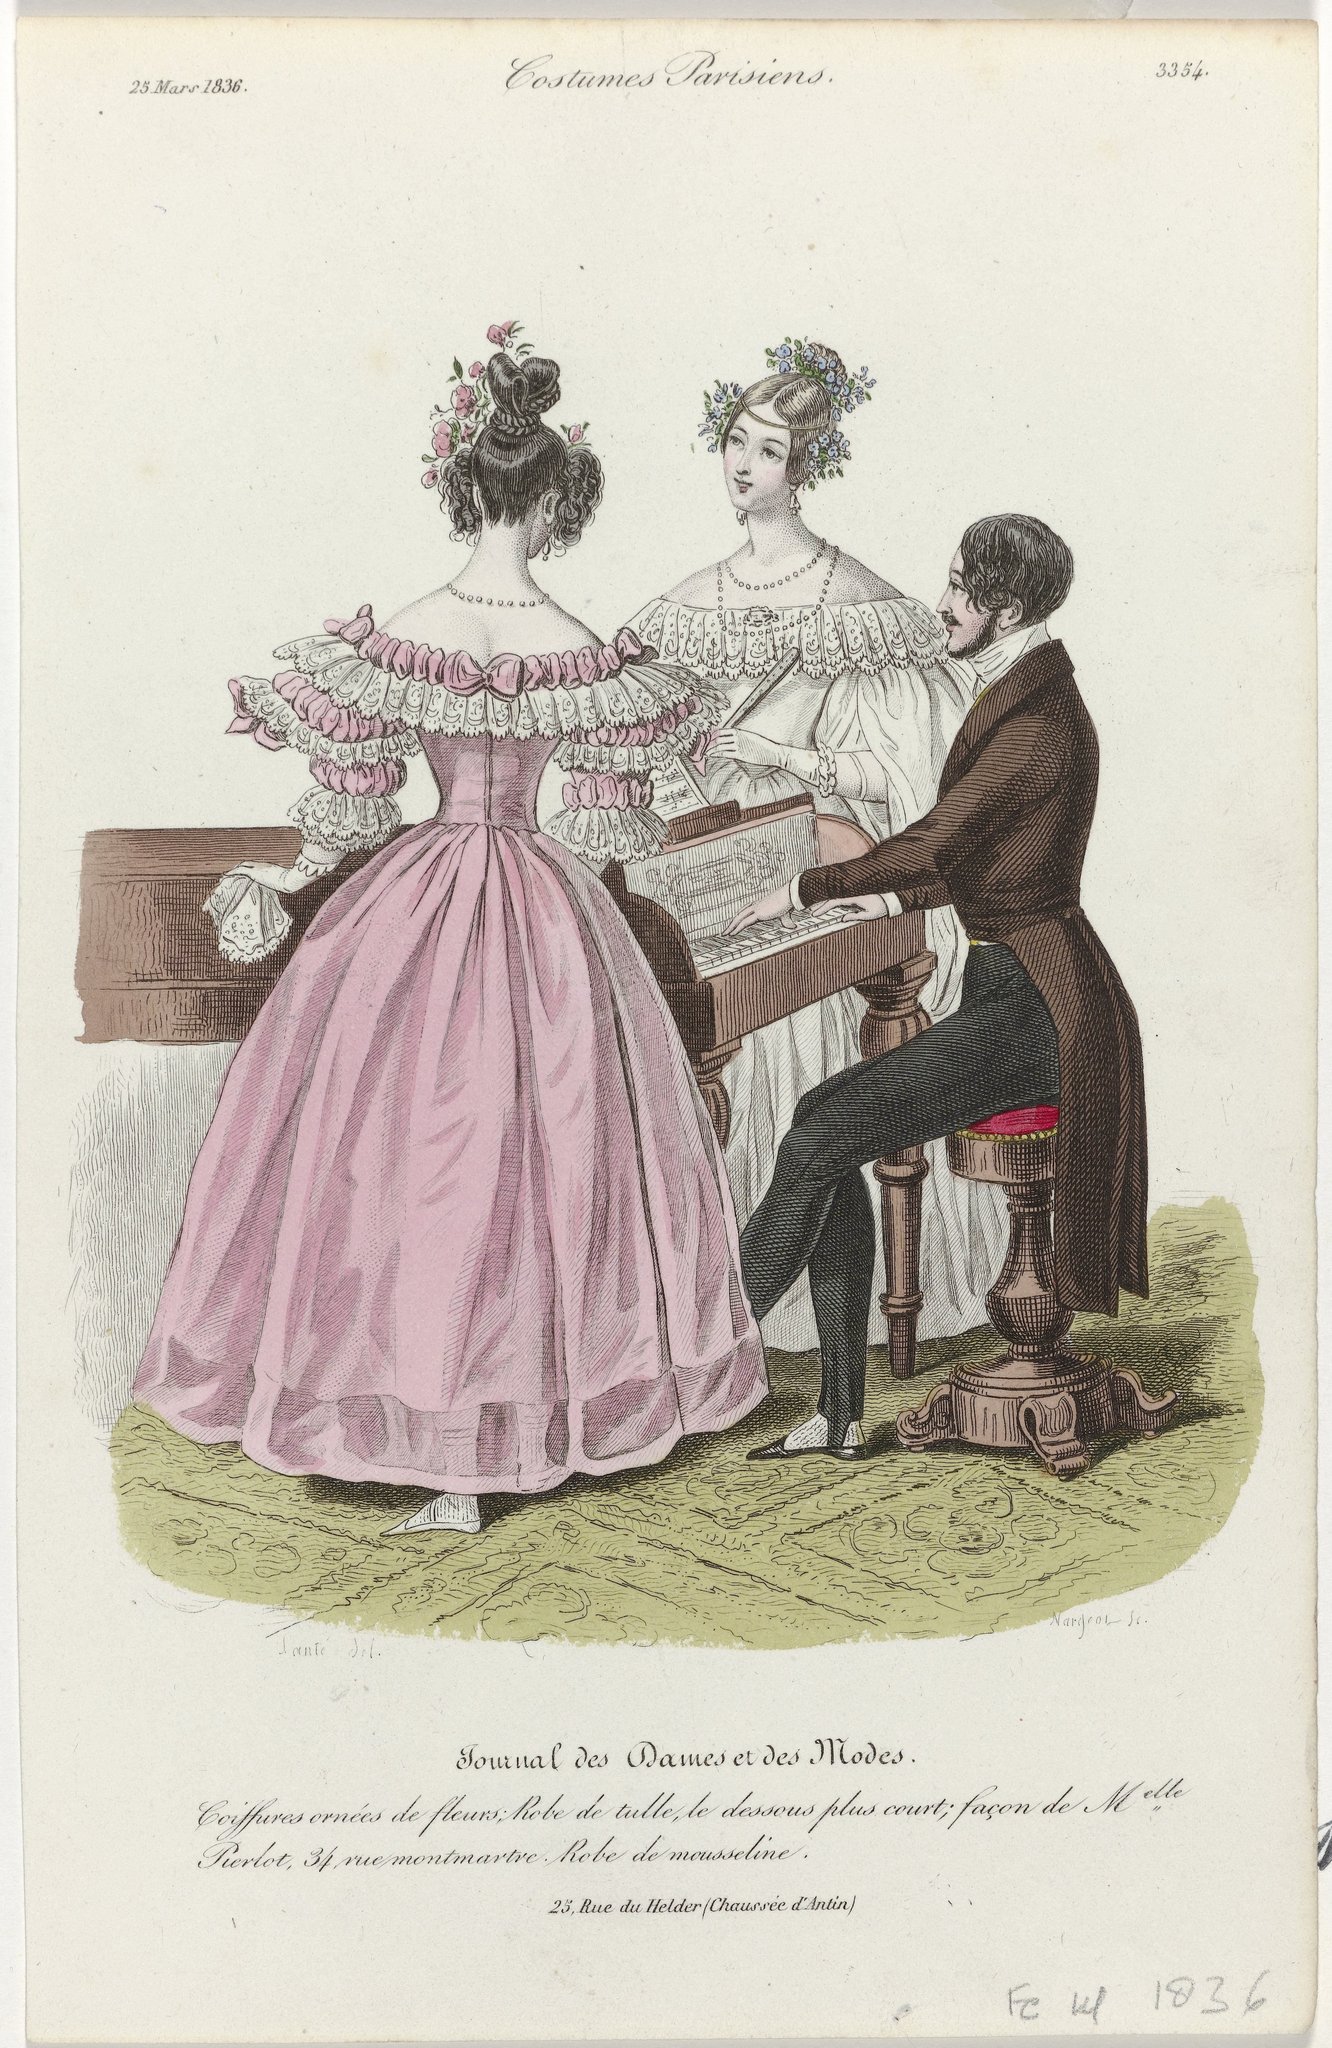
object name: fashion print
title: Journal des Dames et des Modes, Costumes Parisiens, 25 mars 1836, (3354): Coeffures ornées de fleurs (...)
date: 1836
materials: paper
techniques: engraving, hand coloring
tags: flowers, ear-rings (+ women's clothes), handkerchief (+ women's clothes), dress, gown: evening dress (+ women's clothes), grand piano, neck-gear ~ clothing (shawl collar) (+ men's clothes), trousers, breeches, etc. (pantalon) (+ men's clothes), coat (+ men's clothes), styles of hairdress - aa - ~ women, fashion plates, shoes, sandals (+ women's clothes), gloves, mittens, etc. (+ women's clothes), fan (+ women's clothes), necklace (+ women's clothes)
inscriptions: caption: ‘Coiffures ornées de fleurs; Robe de tulle, le dessous plus court; façon de M"elle Pierlot, 34, rue montmartre. Robe de mousseline.’, title: ‘Journal des Dames et des Modes.’, address: ‘25, Rue du Helder (Chaussée d'Antin)’, title: ‘Costumes Parisiens.’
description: Twee vrouwen bij een piano, van wie één op de rug gezien, terwijl een man piano speelt. Hij draagt een bruine jas met slippen op een zwarte spanbroek. Volgens het onderschrift: 'Coiffures' versierd met bloemen. Avondjapon van tule, met een kortere onderjurk, uitgevoerd op de manier van Pierlot. Avondjapon van mousseline. Prent uit het modetijdschrift Journal des Dames et des Mode (1797-1839).